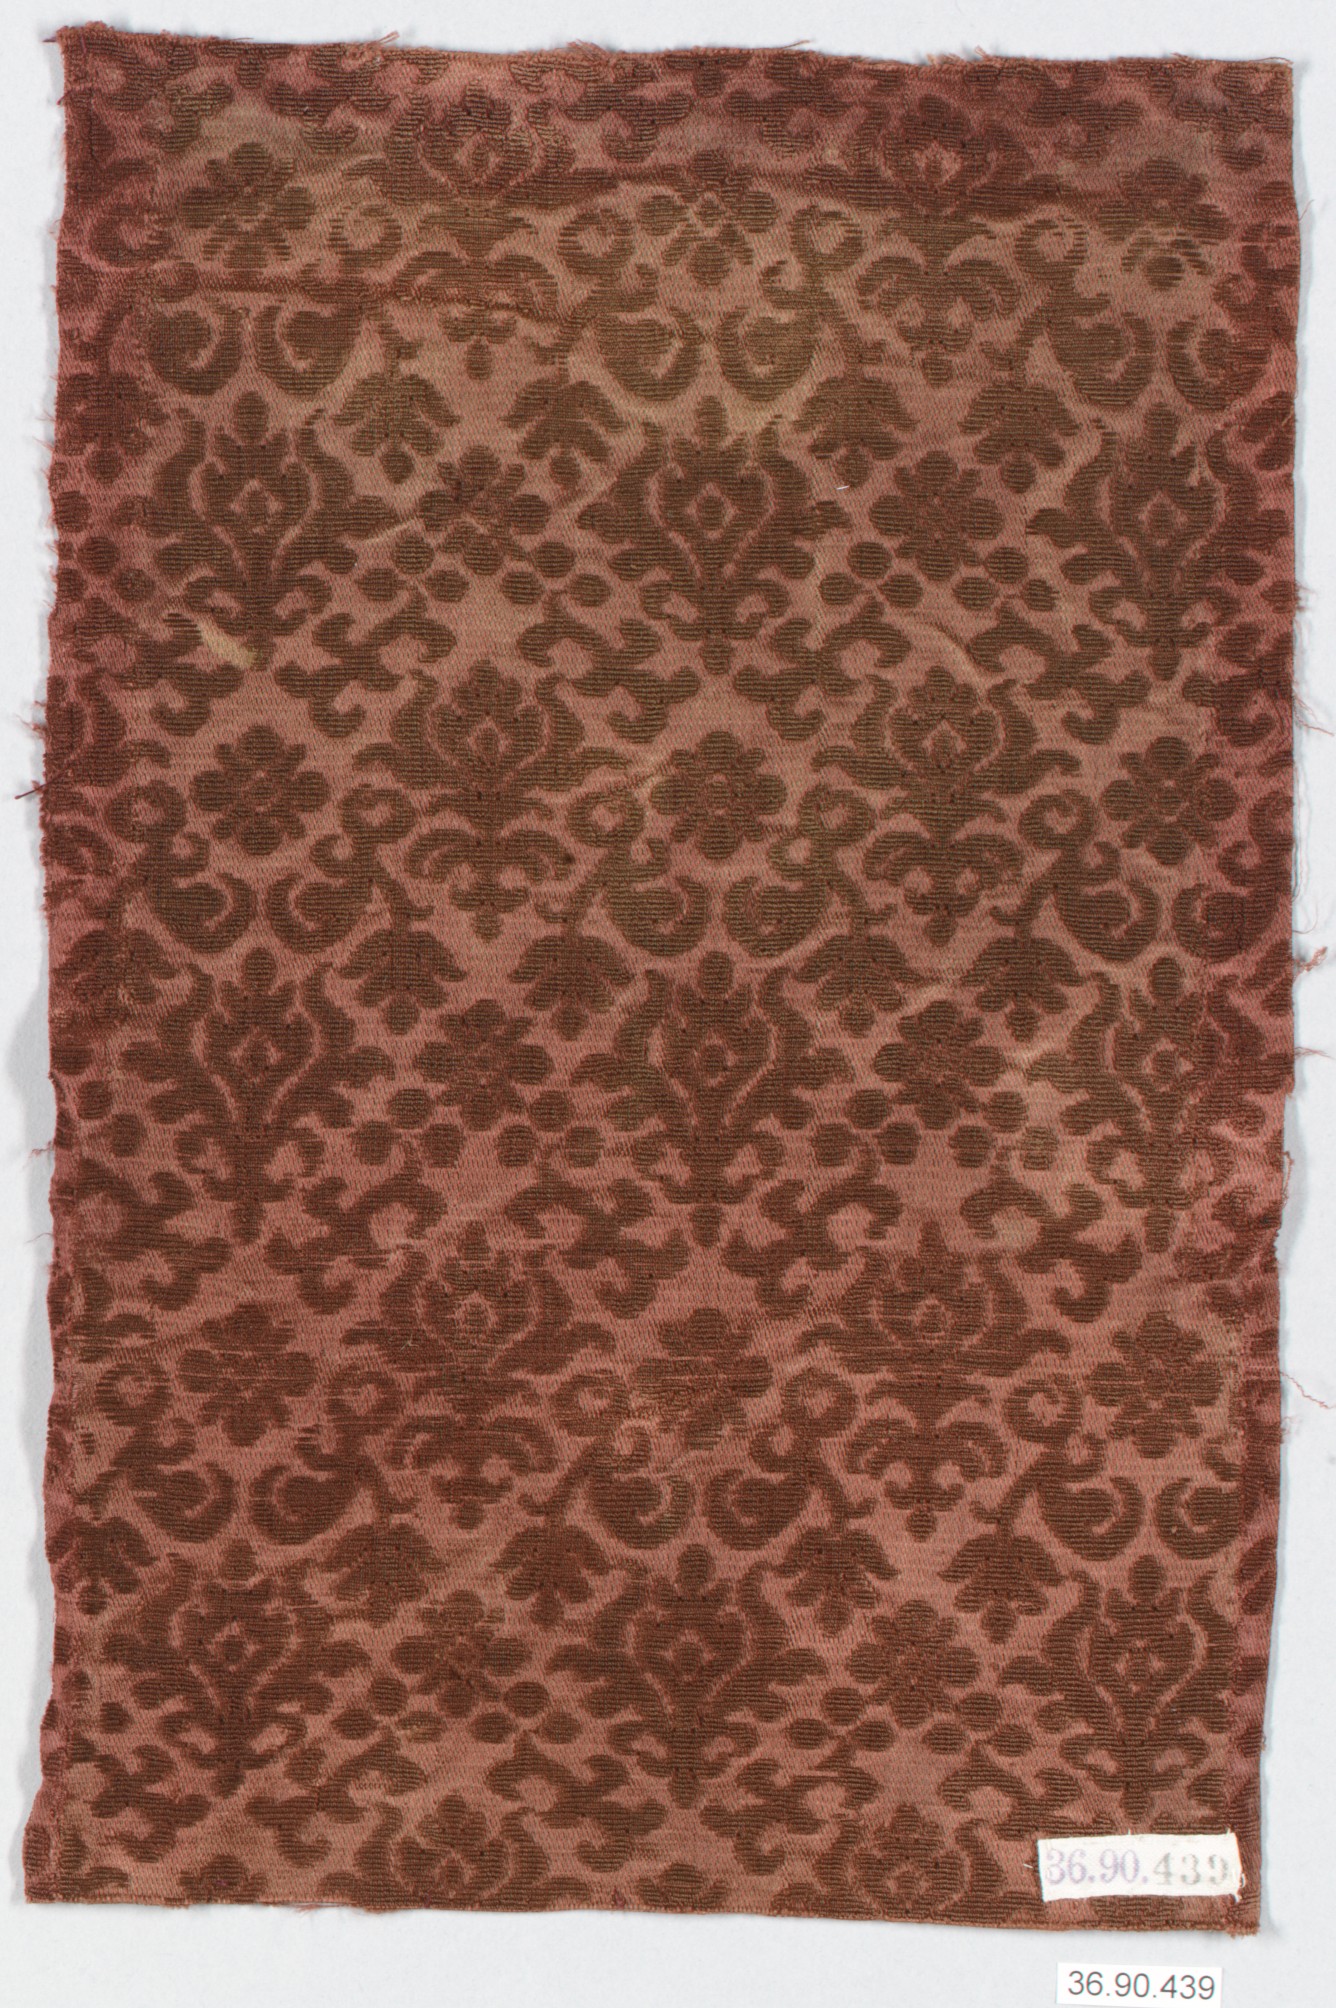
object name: piece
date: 1501-1700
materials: silk